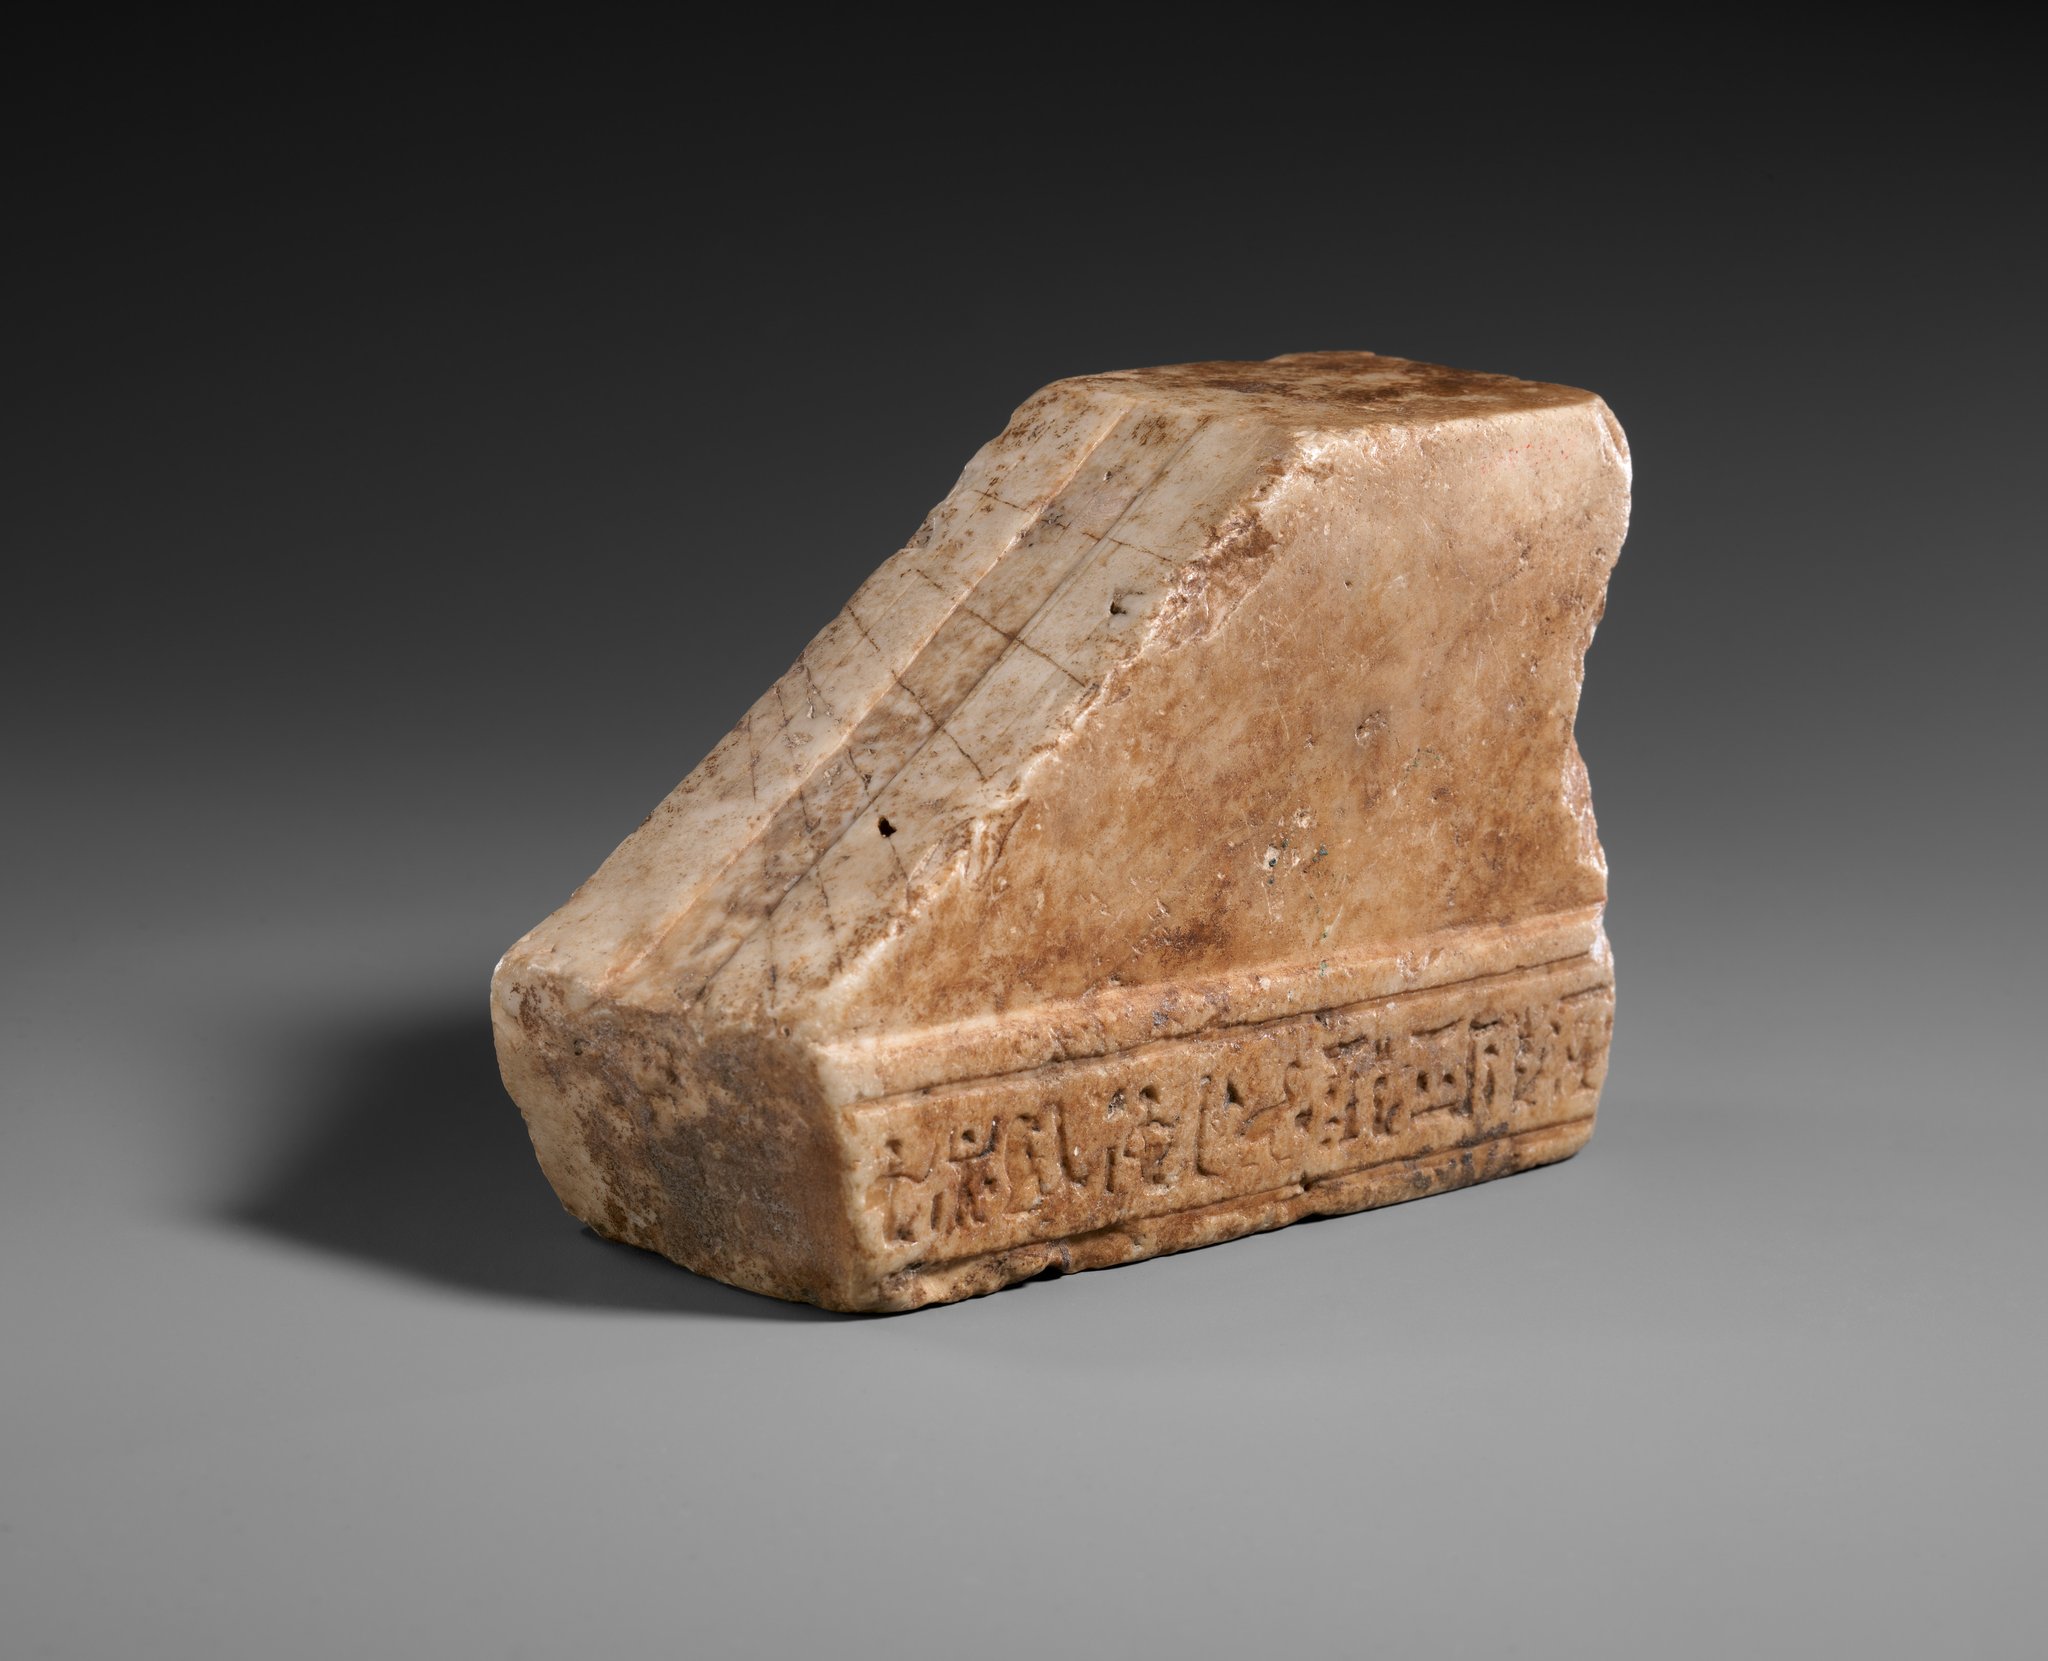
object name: sun dial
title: Shadow Clock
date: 306-30 BCE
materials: marble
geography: egypt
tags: hieroglyphs,sundials